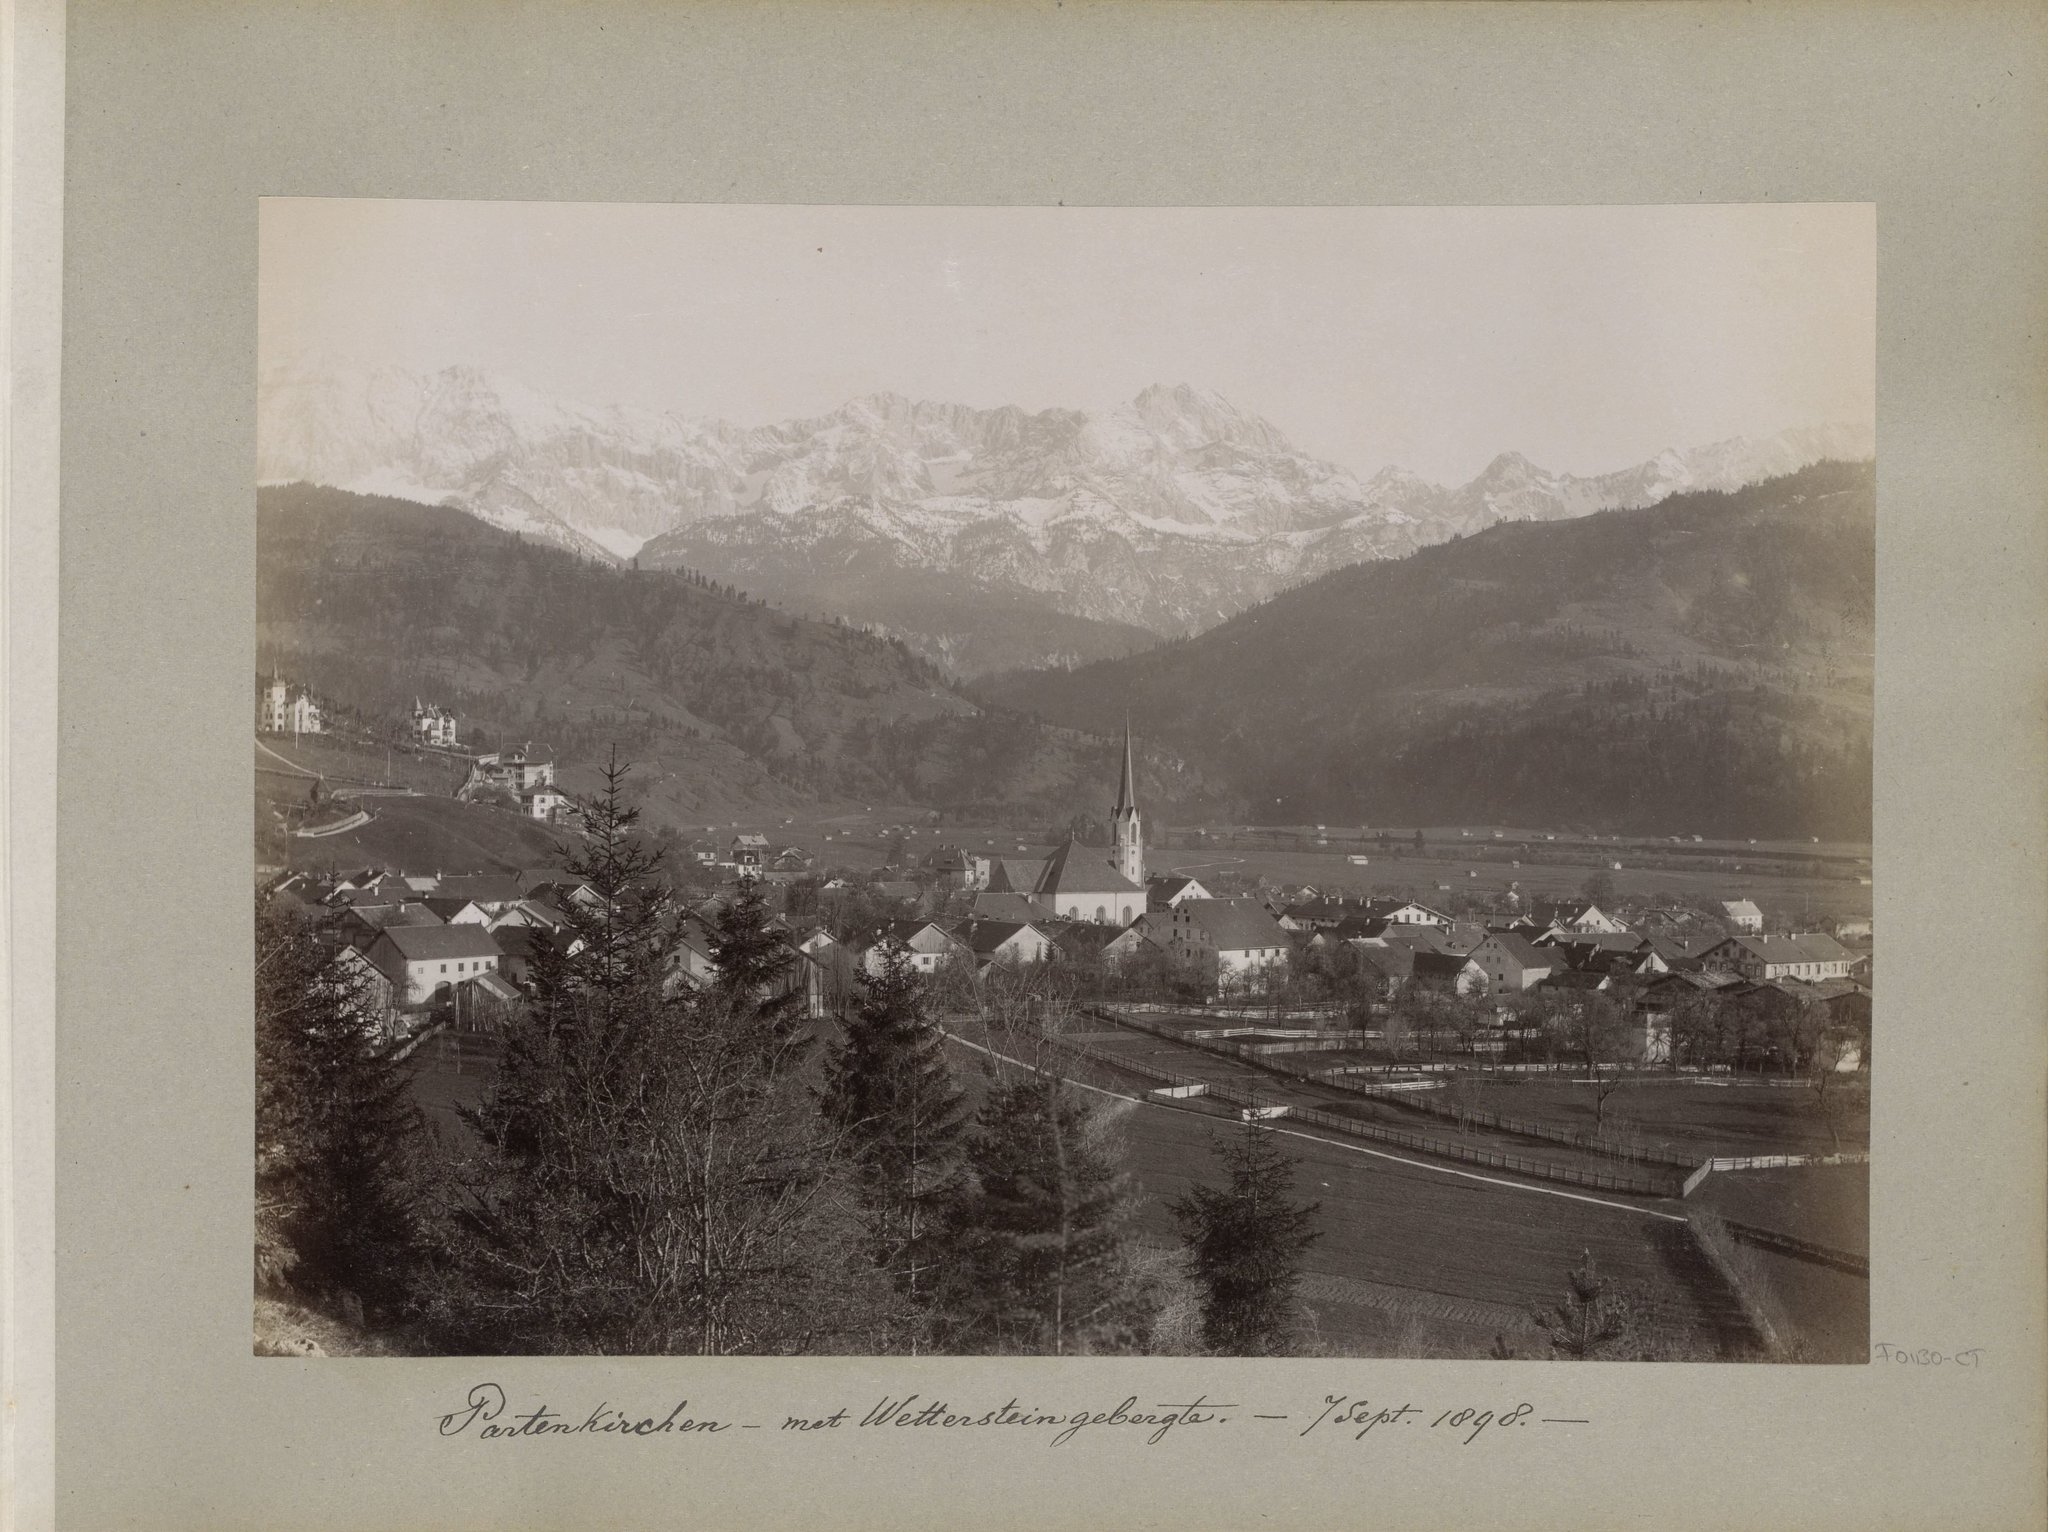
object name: photograph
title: Gezicht op Partenkirchen met op de achtergrond het Wettersteingebergte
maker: Anonymous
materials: paper, photographic support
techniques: albumen print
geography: garmisch-partenkirchen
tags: prospect of village, silhouette of village, mountain-range, snow peaks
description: Onderdeel van Reisalbum met foto's van bezienswaardigheden in Frankrijk, Spanje, Italië, Duitsland, Zwitserland en Oostenrijk.